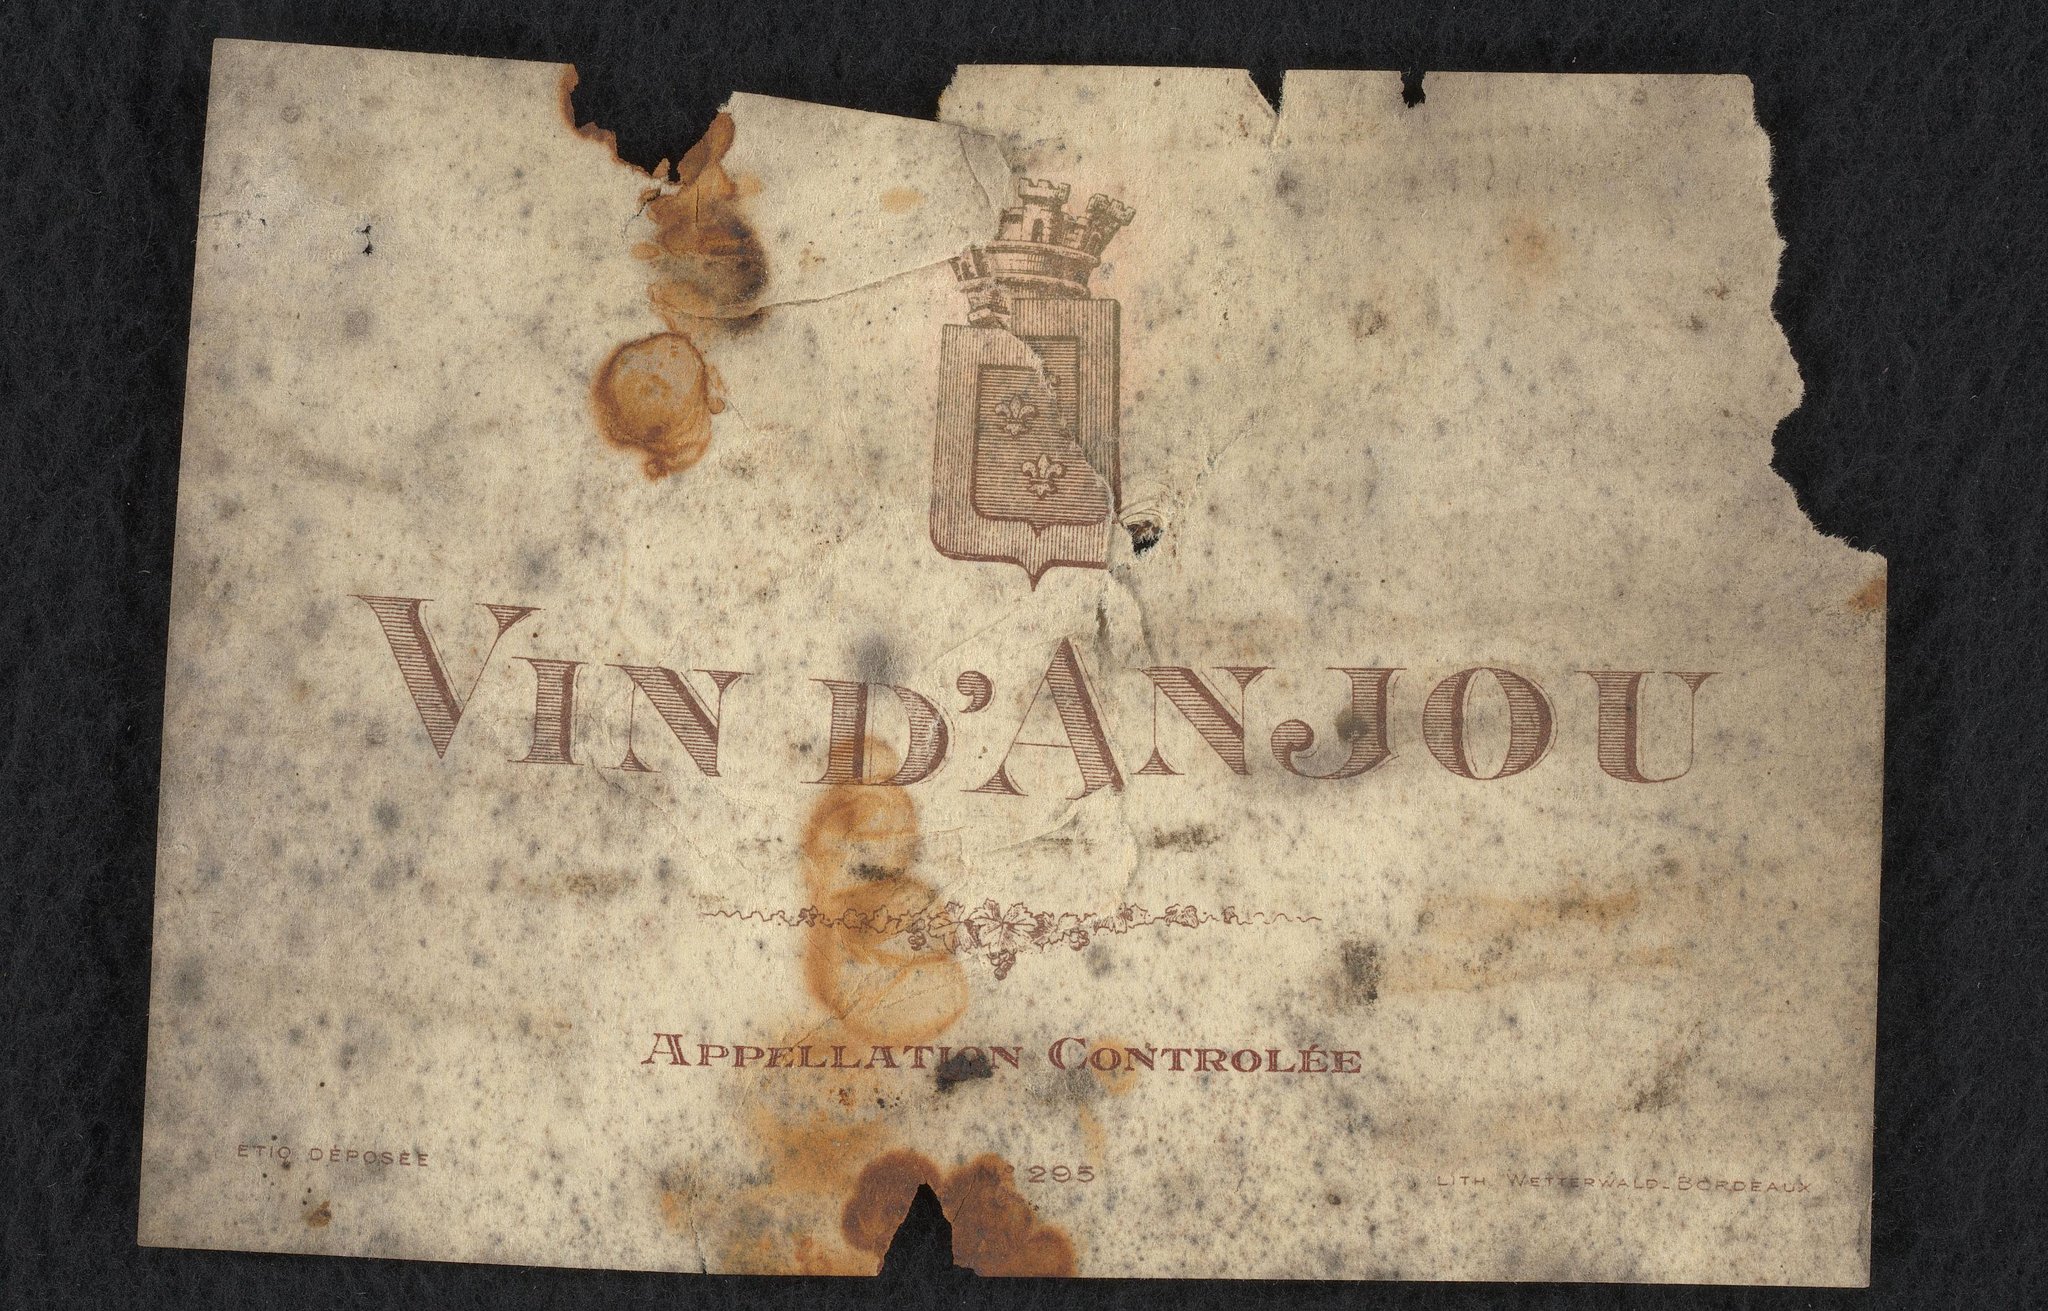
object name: print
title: Wijnetiket Vin d'Anjou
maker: Anonymous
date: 1900-1955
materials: paper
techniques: lithograph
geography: bordeaux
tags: wine ~ alcoholic drinks